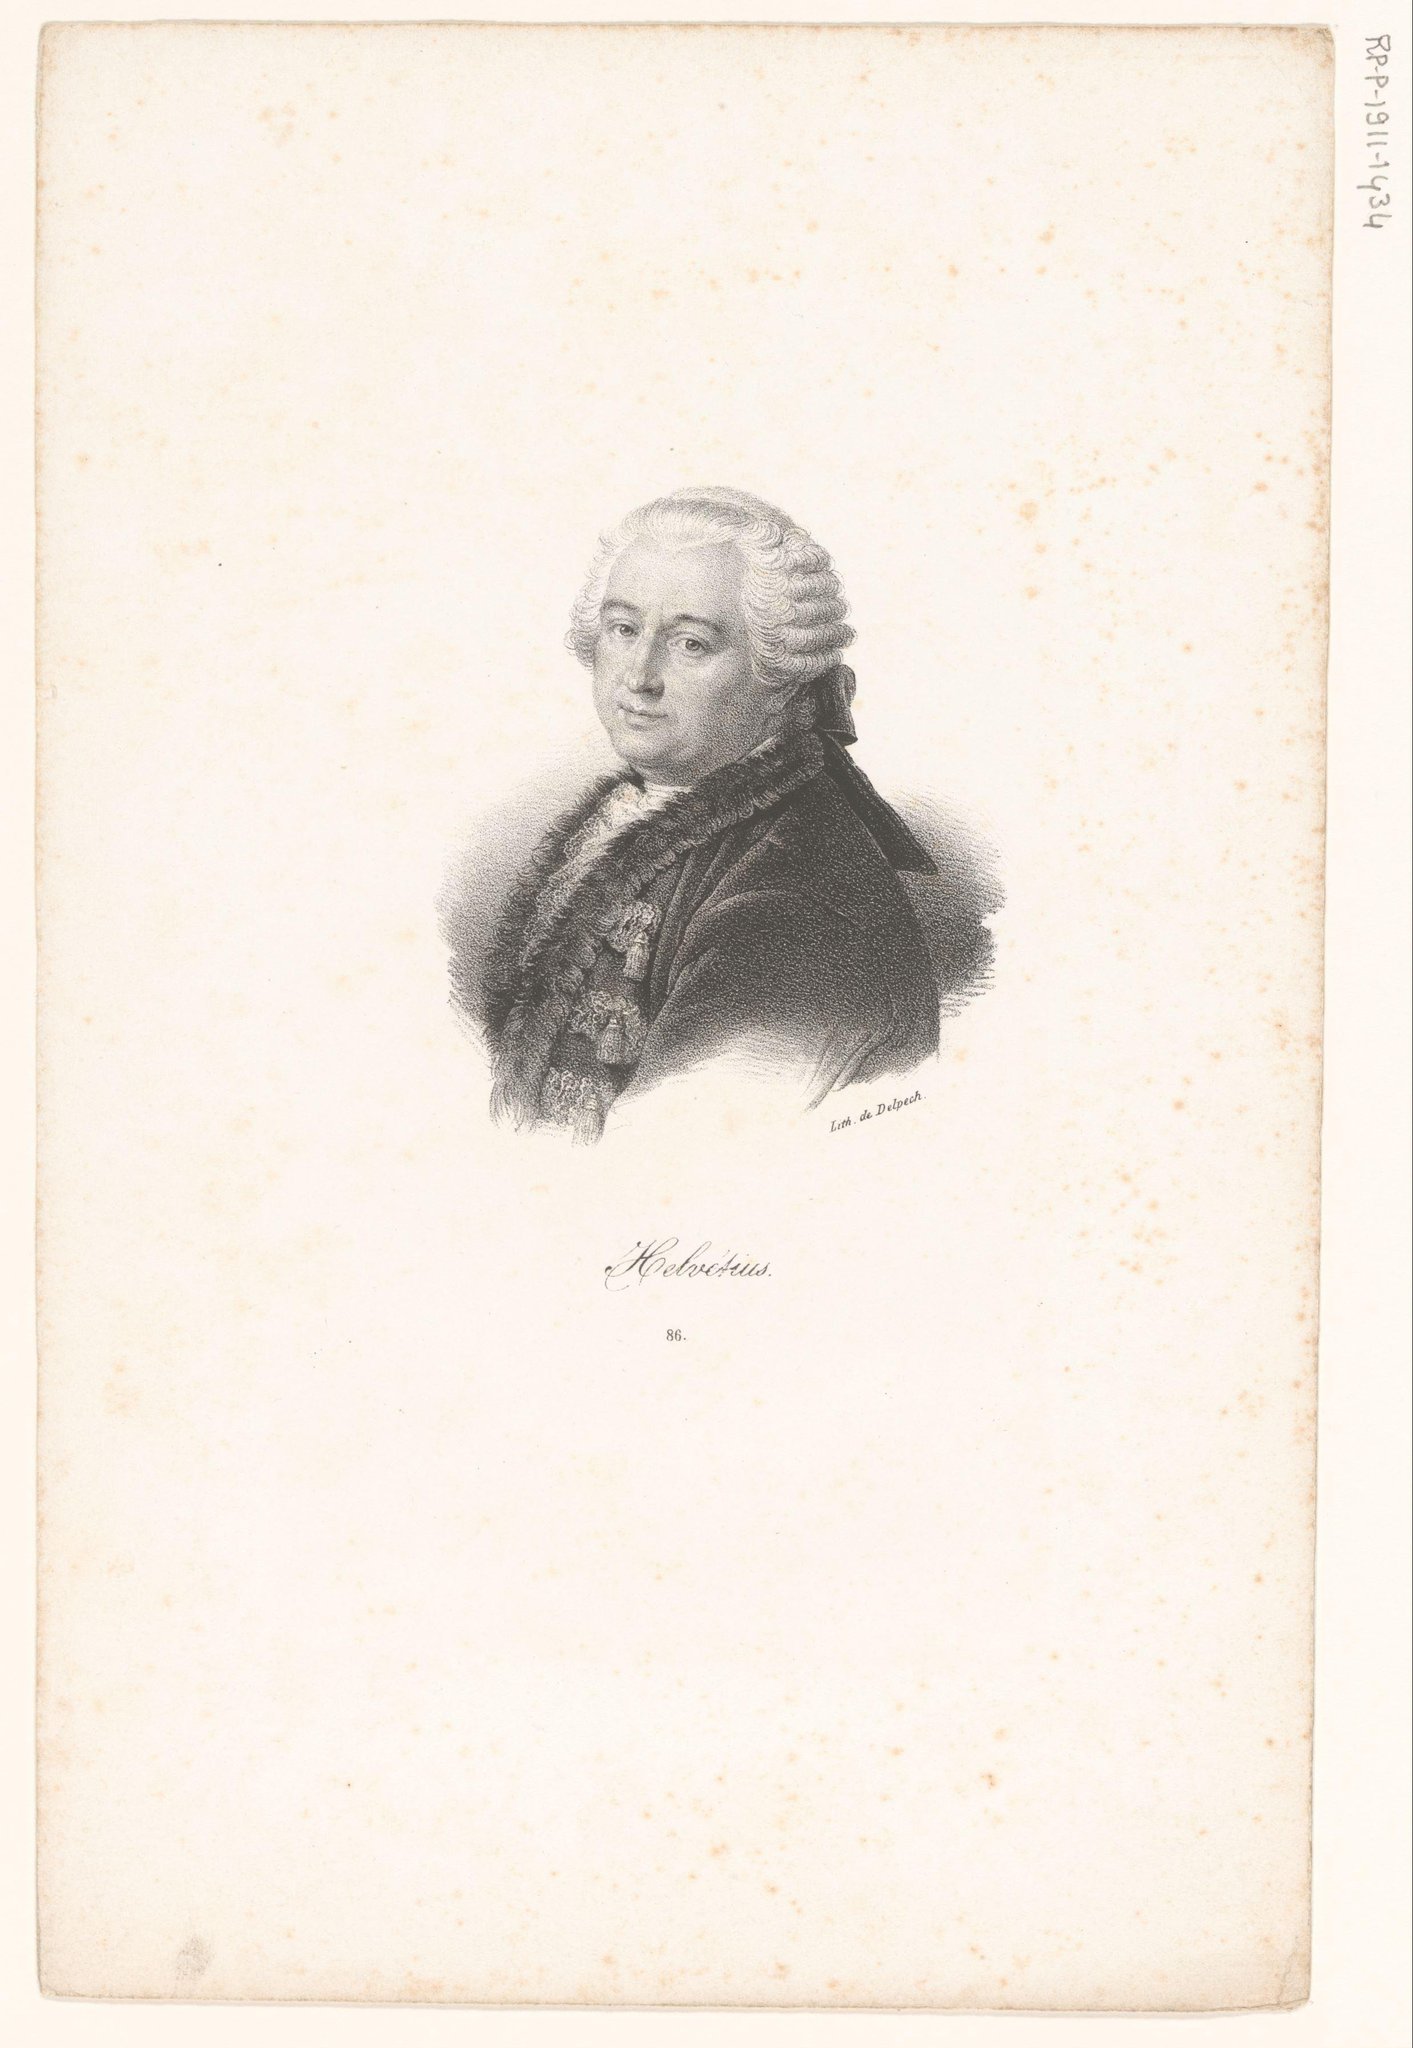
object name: print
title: Portret van Claude-Adrien Helvétius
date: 1818-1842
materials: paper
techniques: lithograph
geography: paris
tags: historical persons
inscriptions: collector's mark: Lugt 2228a